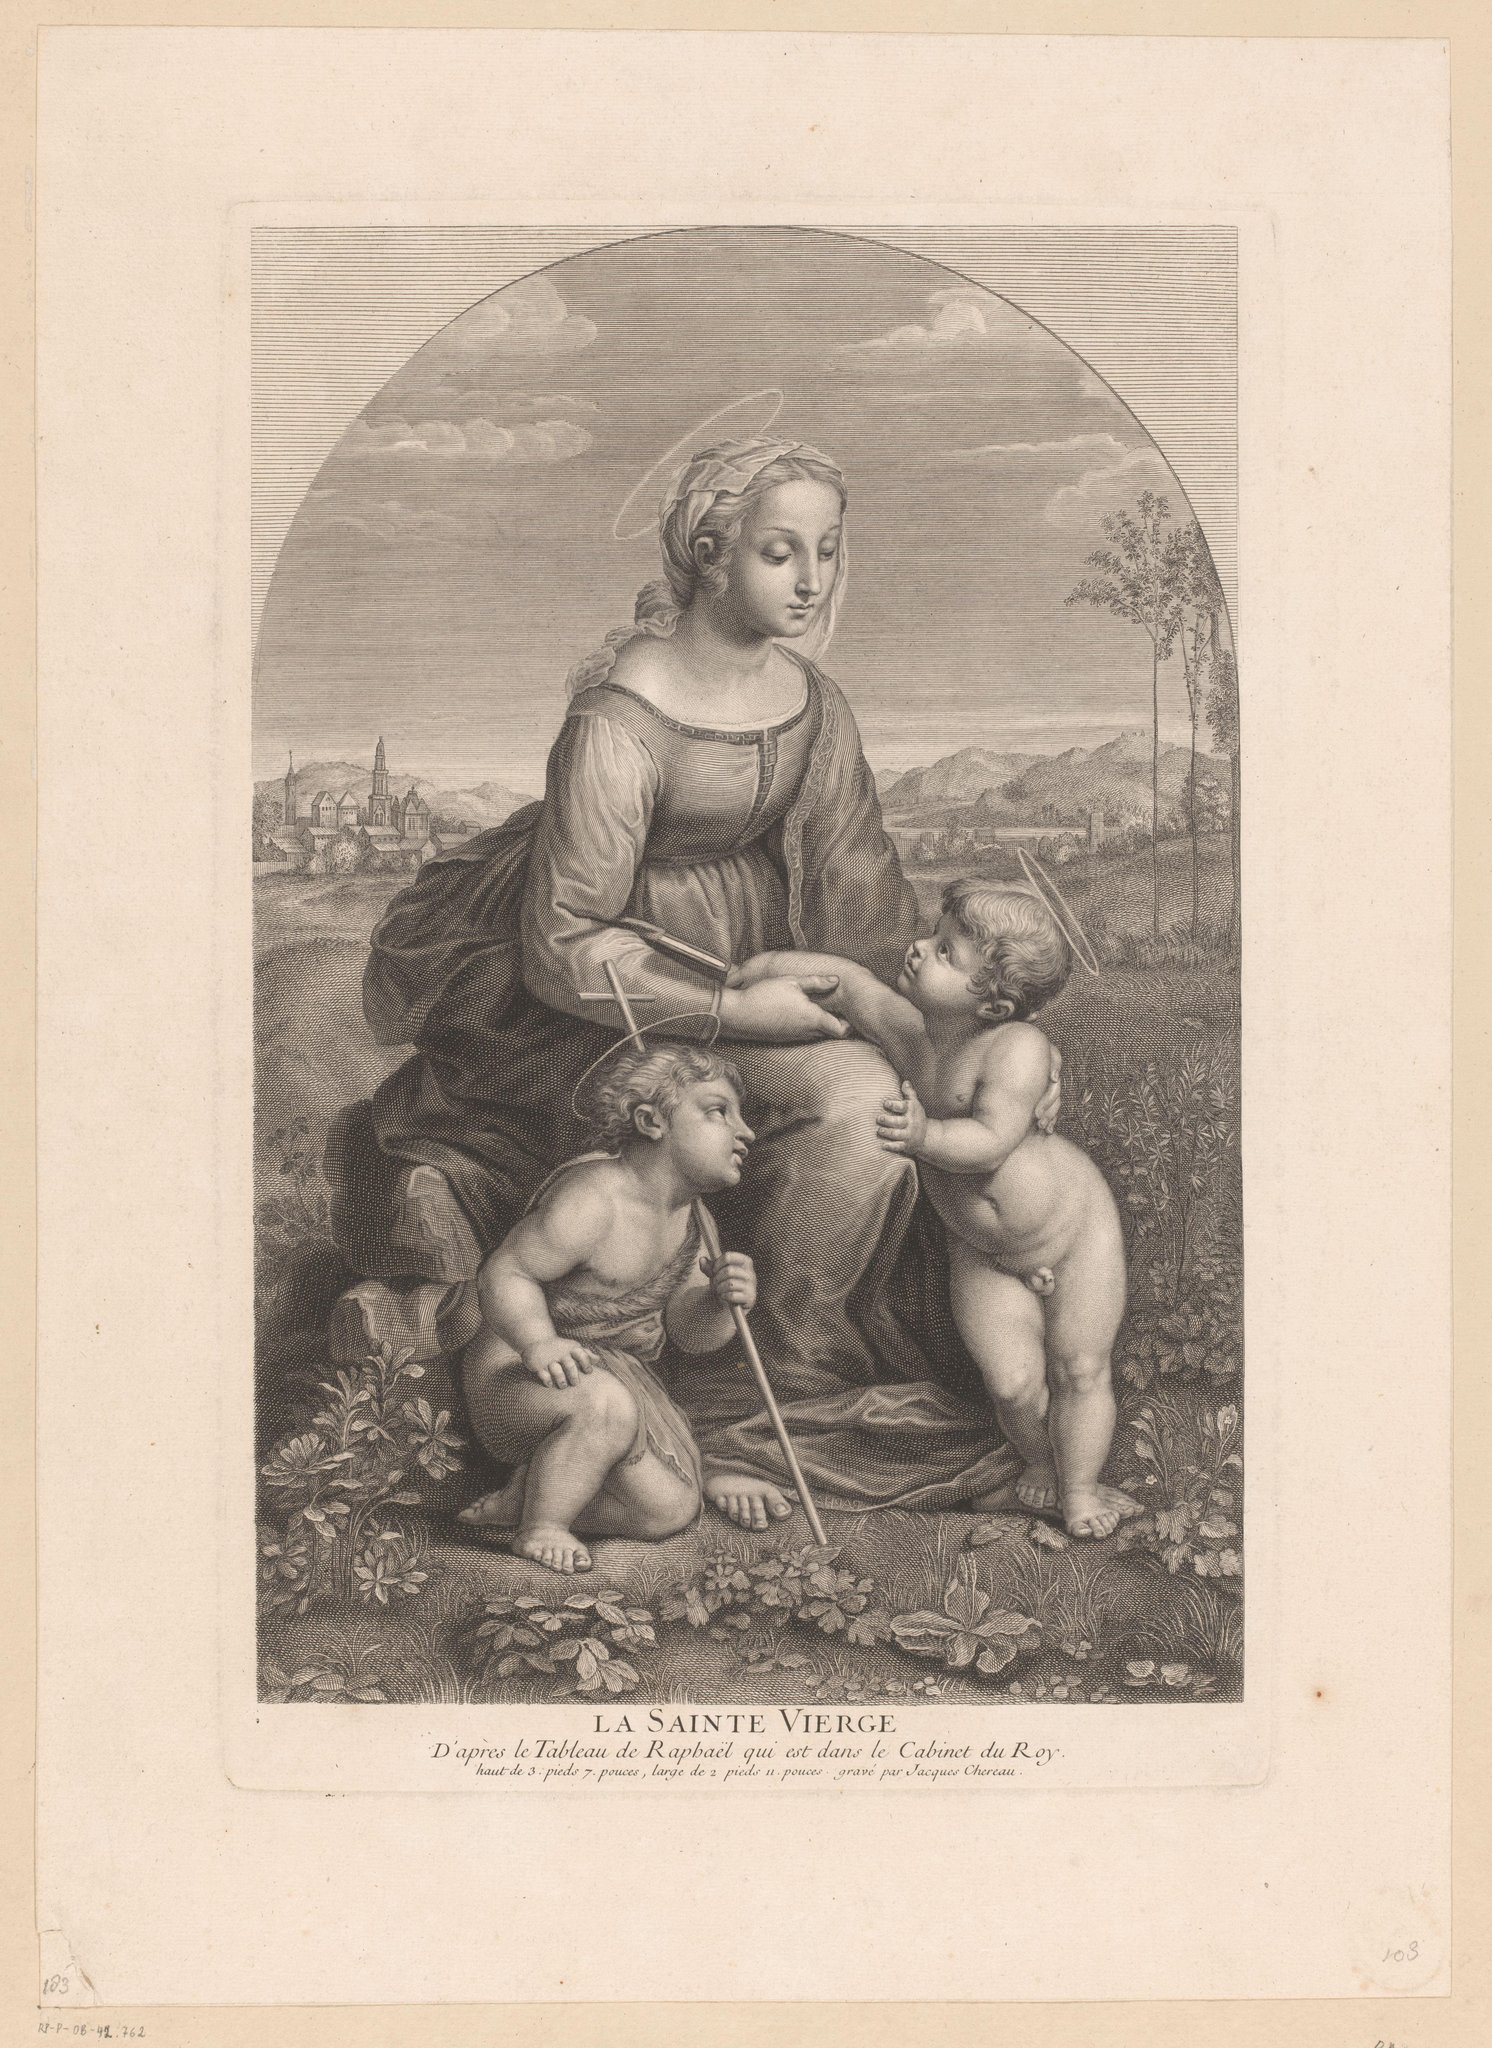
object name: print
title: La Sainte Vierge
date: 1729-1740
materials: paper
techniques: engraving, etching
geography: france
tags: mary and the christ-child with john the baptist (as child)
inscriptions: collector's mark: Lugt 240